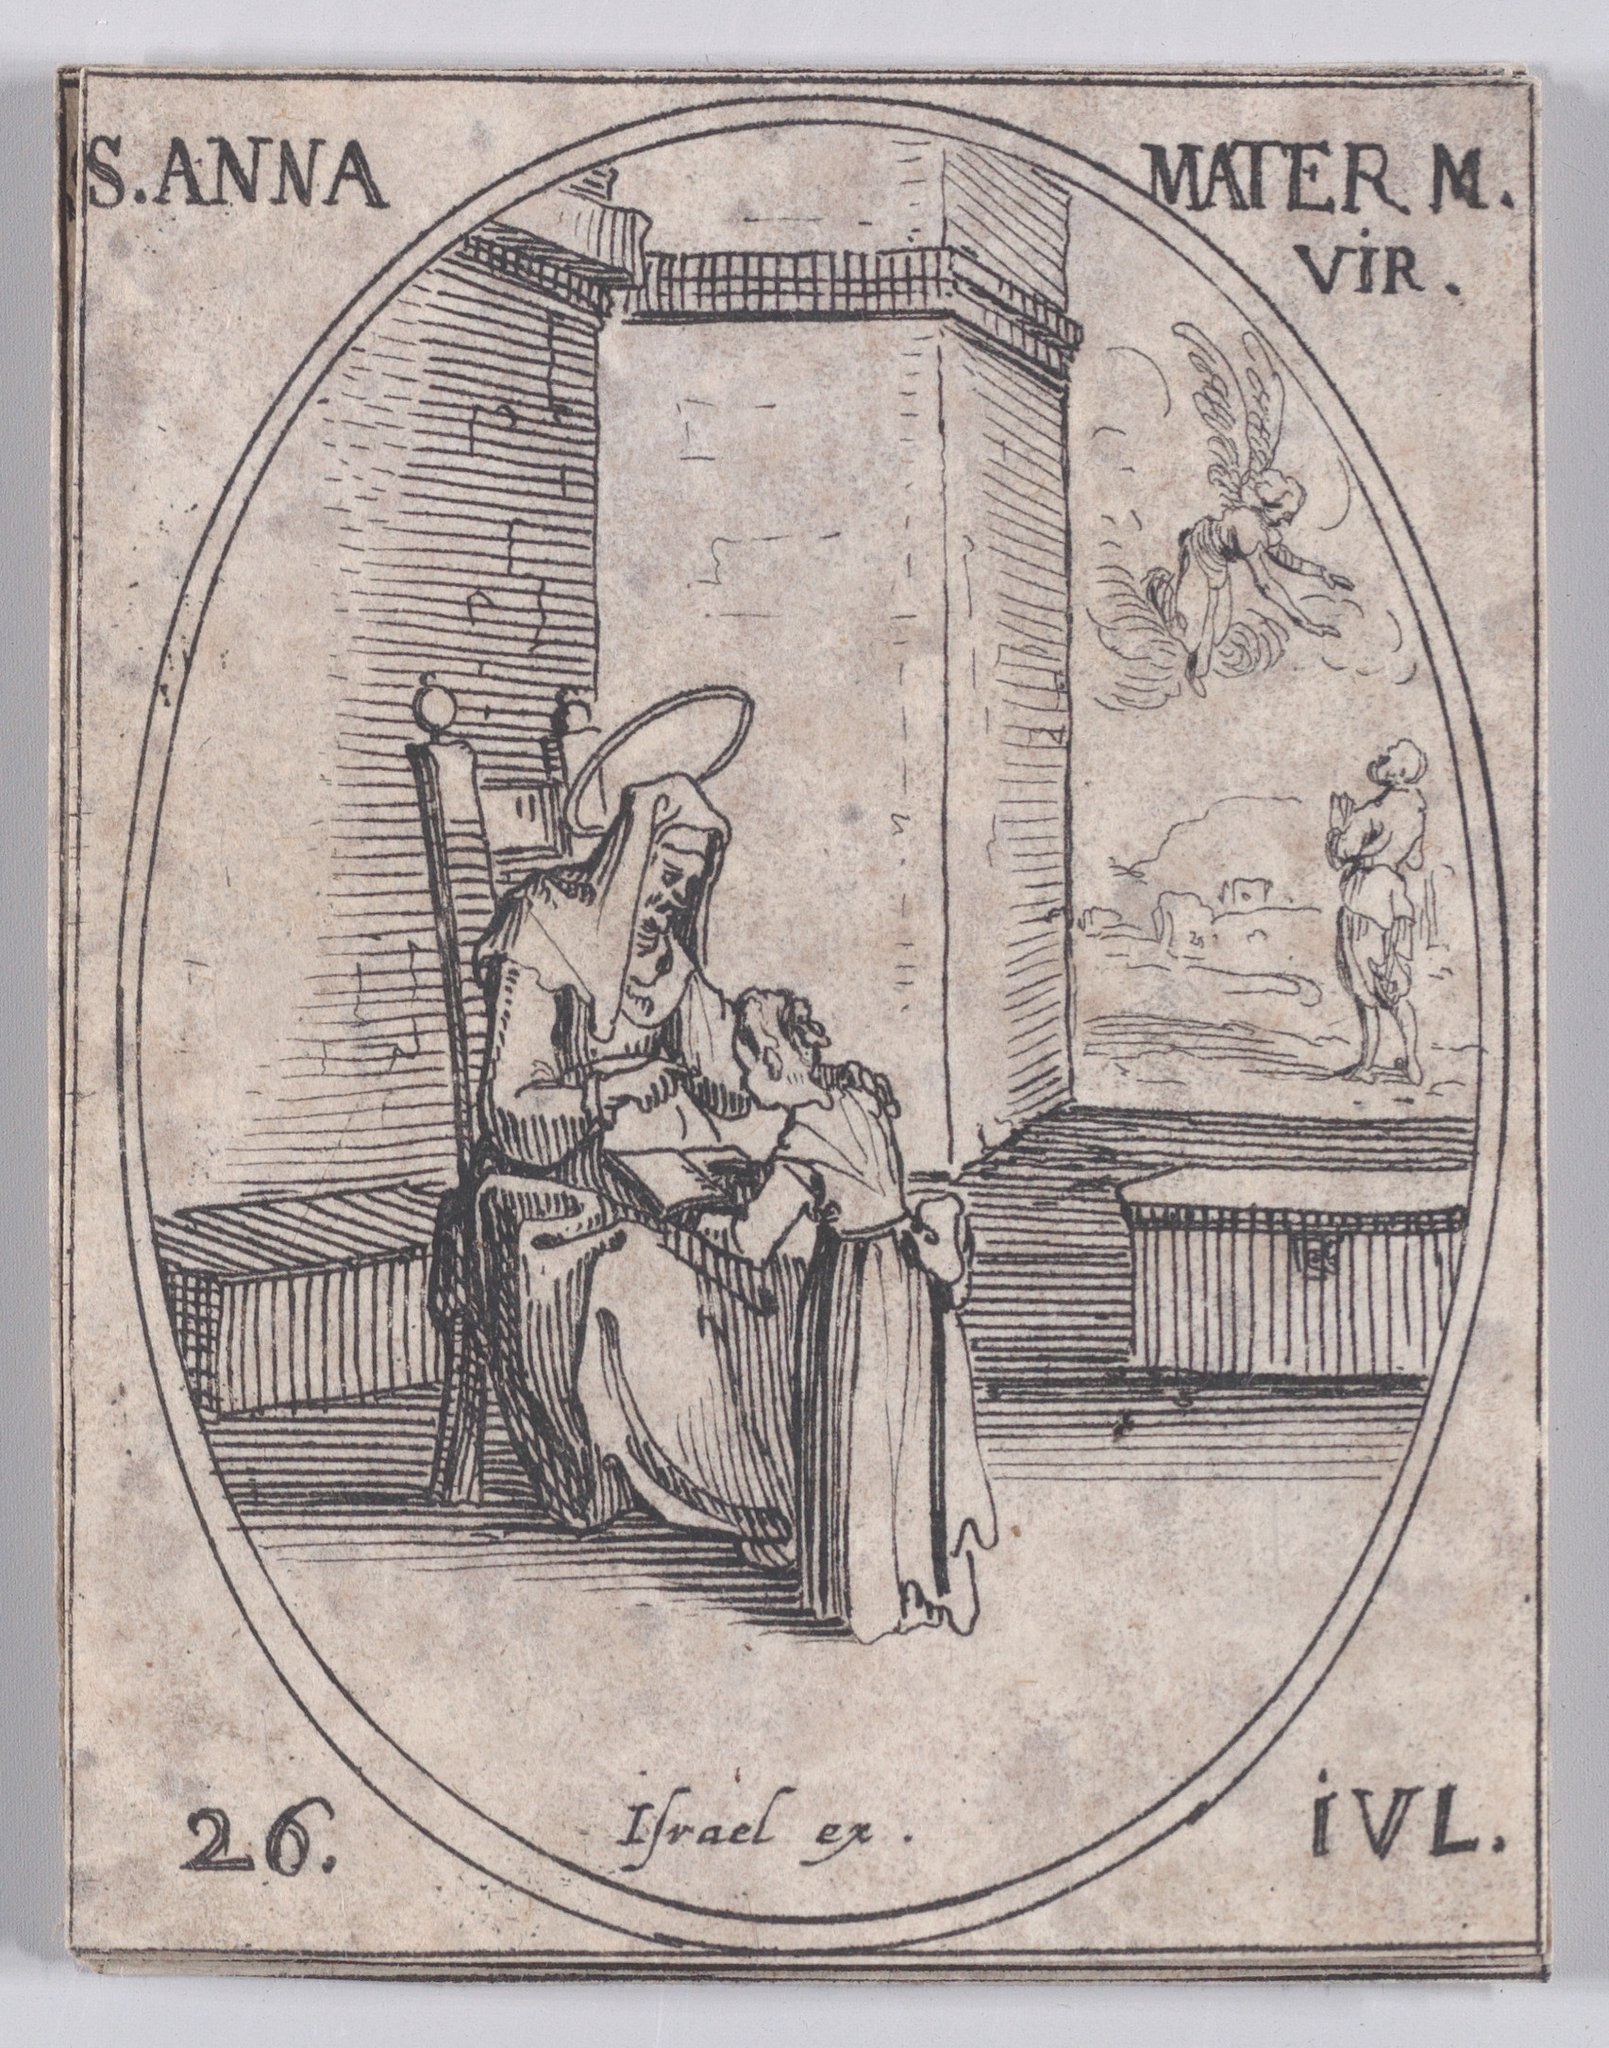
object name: print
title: Ste. Anne, Mère de la Sainte Vierge (St. Anne, Mother of the Virgin), July 26th, from "Les Images De Tous Les Saincts et Saintes de L'Année" (Images of All of the Saints and Religious Events of the Year)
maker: jacques callot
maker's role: artist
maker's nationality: french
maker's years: 1592-1635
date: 1636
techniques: etching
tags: girls,women,saint anne